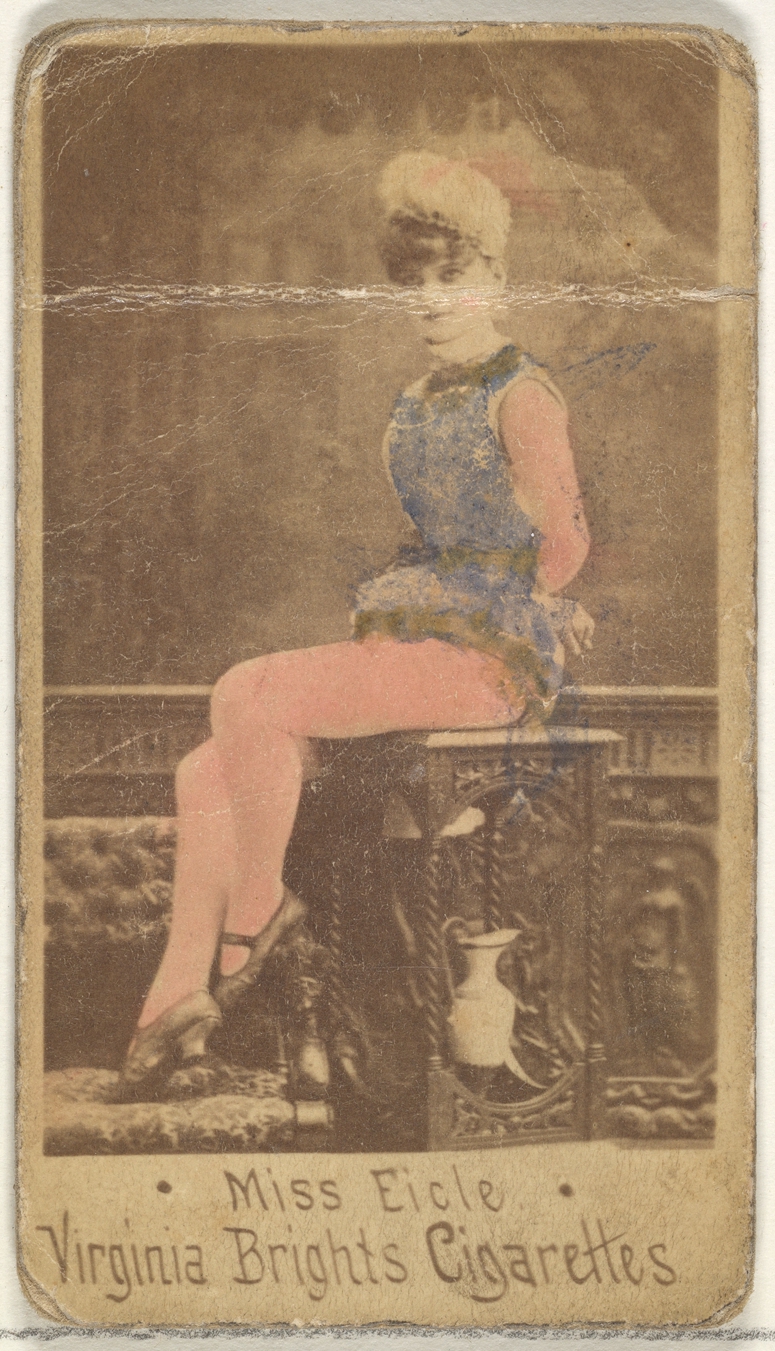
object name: photograph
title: Miss Eicle, from the Actors and Actresses series (N45, Type 1) for Virginia Brights Cigarettes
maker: allen & ginter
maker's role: publisher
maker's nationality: american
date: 1888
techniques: albumen silver print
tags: portraits,women,actresses